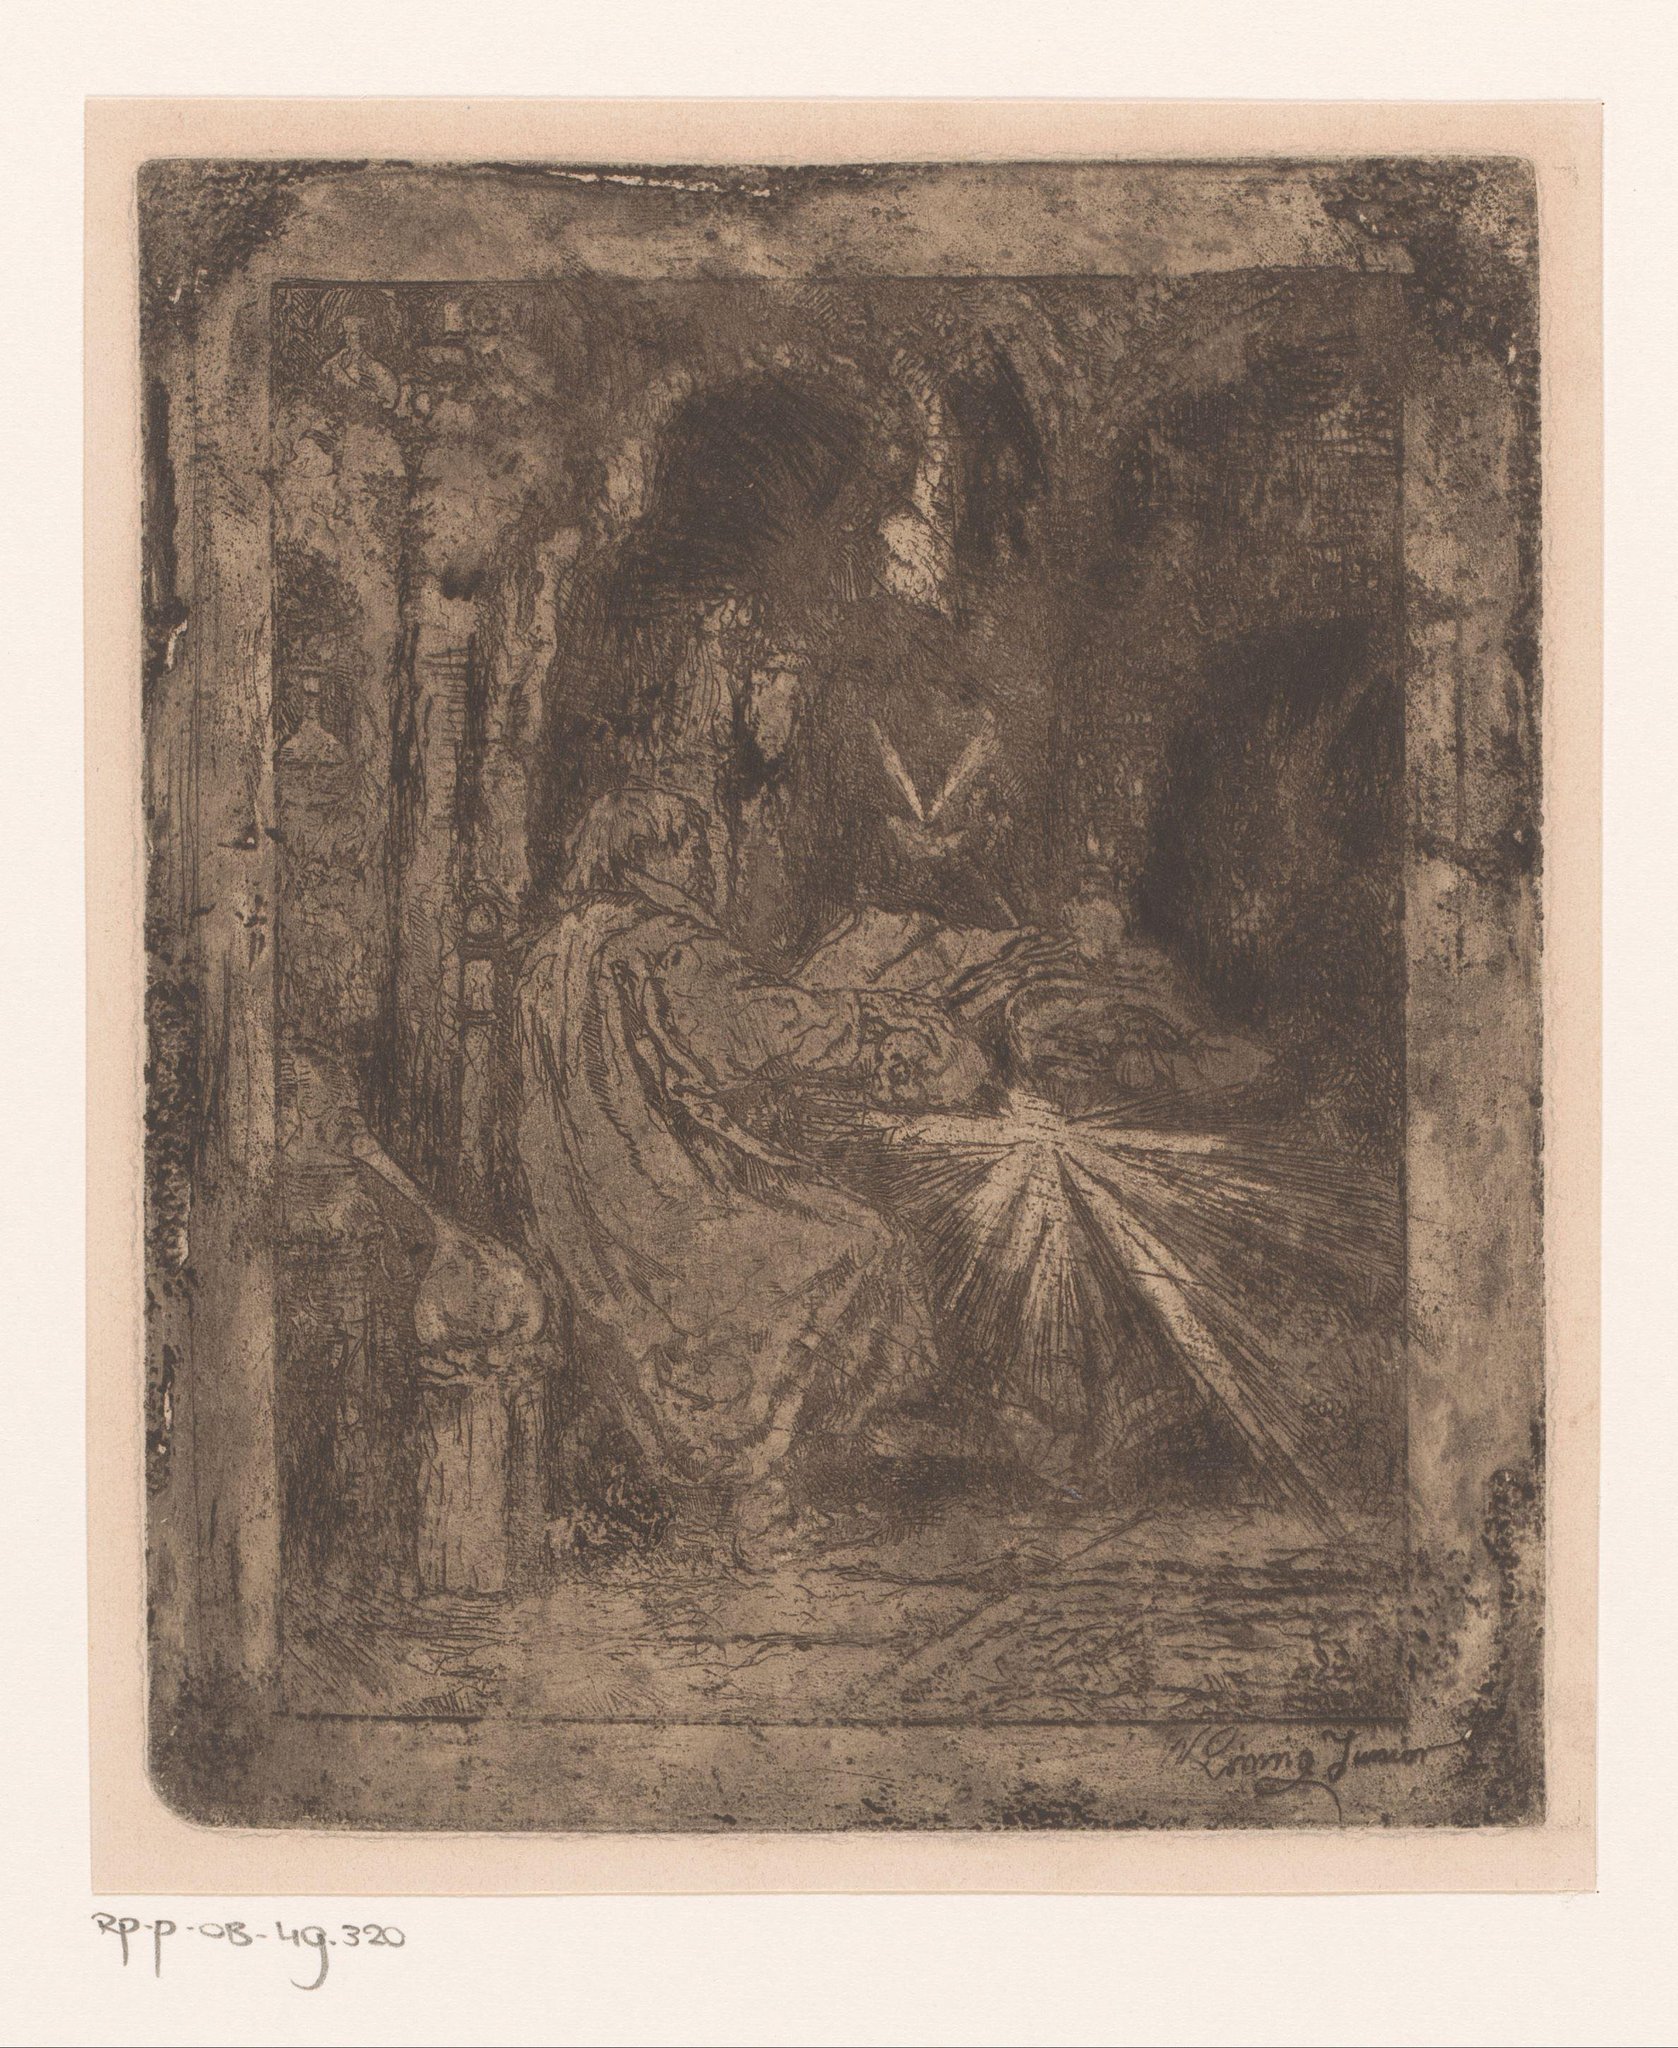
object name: print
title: Faust in zijn studeerkamer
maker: willem linnig (ii)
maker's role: print maker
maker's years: 1842-1890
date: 1868-1876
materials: paper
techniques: aquatint, etching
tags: head (human), scholar in his study, book - mm - book open, faust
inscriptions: collector's mark: Lugt 2228